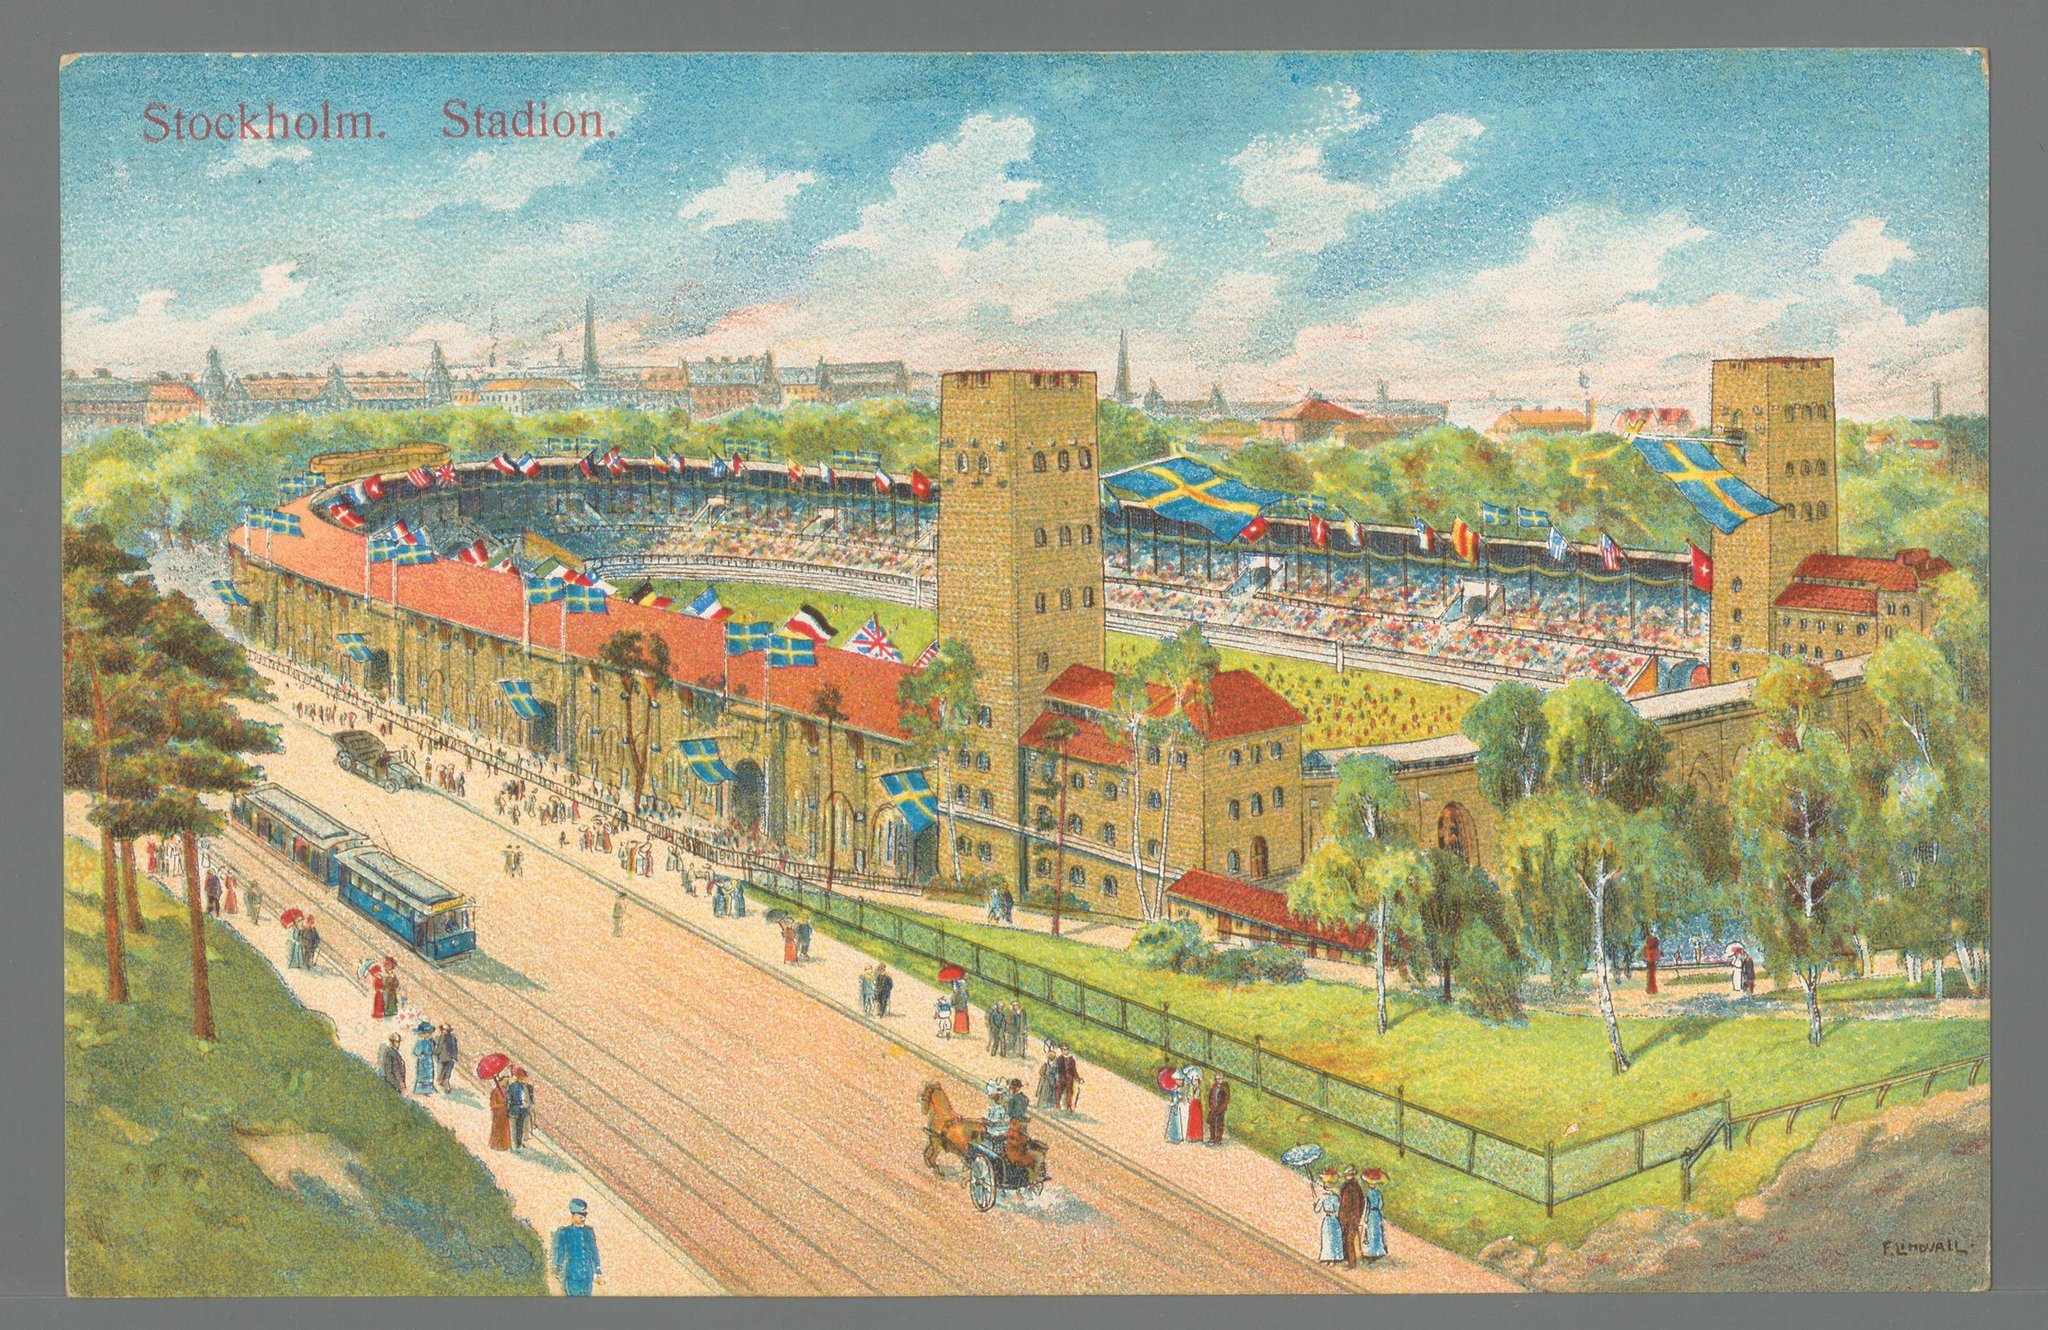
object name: ansichtkaart, prentbriefkaart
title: Stockholm. Stadion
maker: f. lindvall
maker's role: draughtsman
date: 1905-1912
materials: cardboard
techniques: lithograph, writing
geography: stockholm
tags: church (exterior), opera house